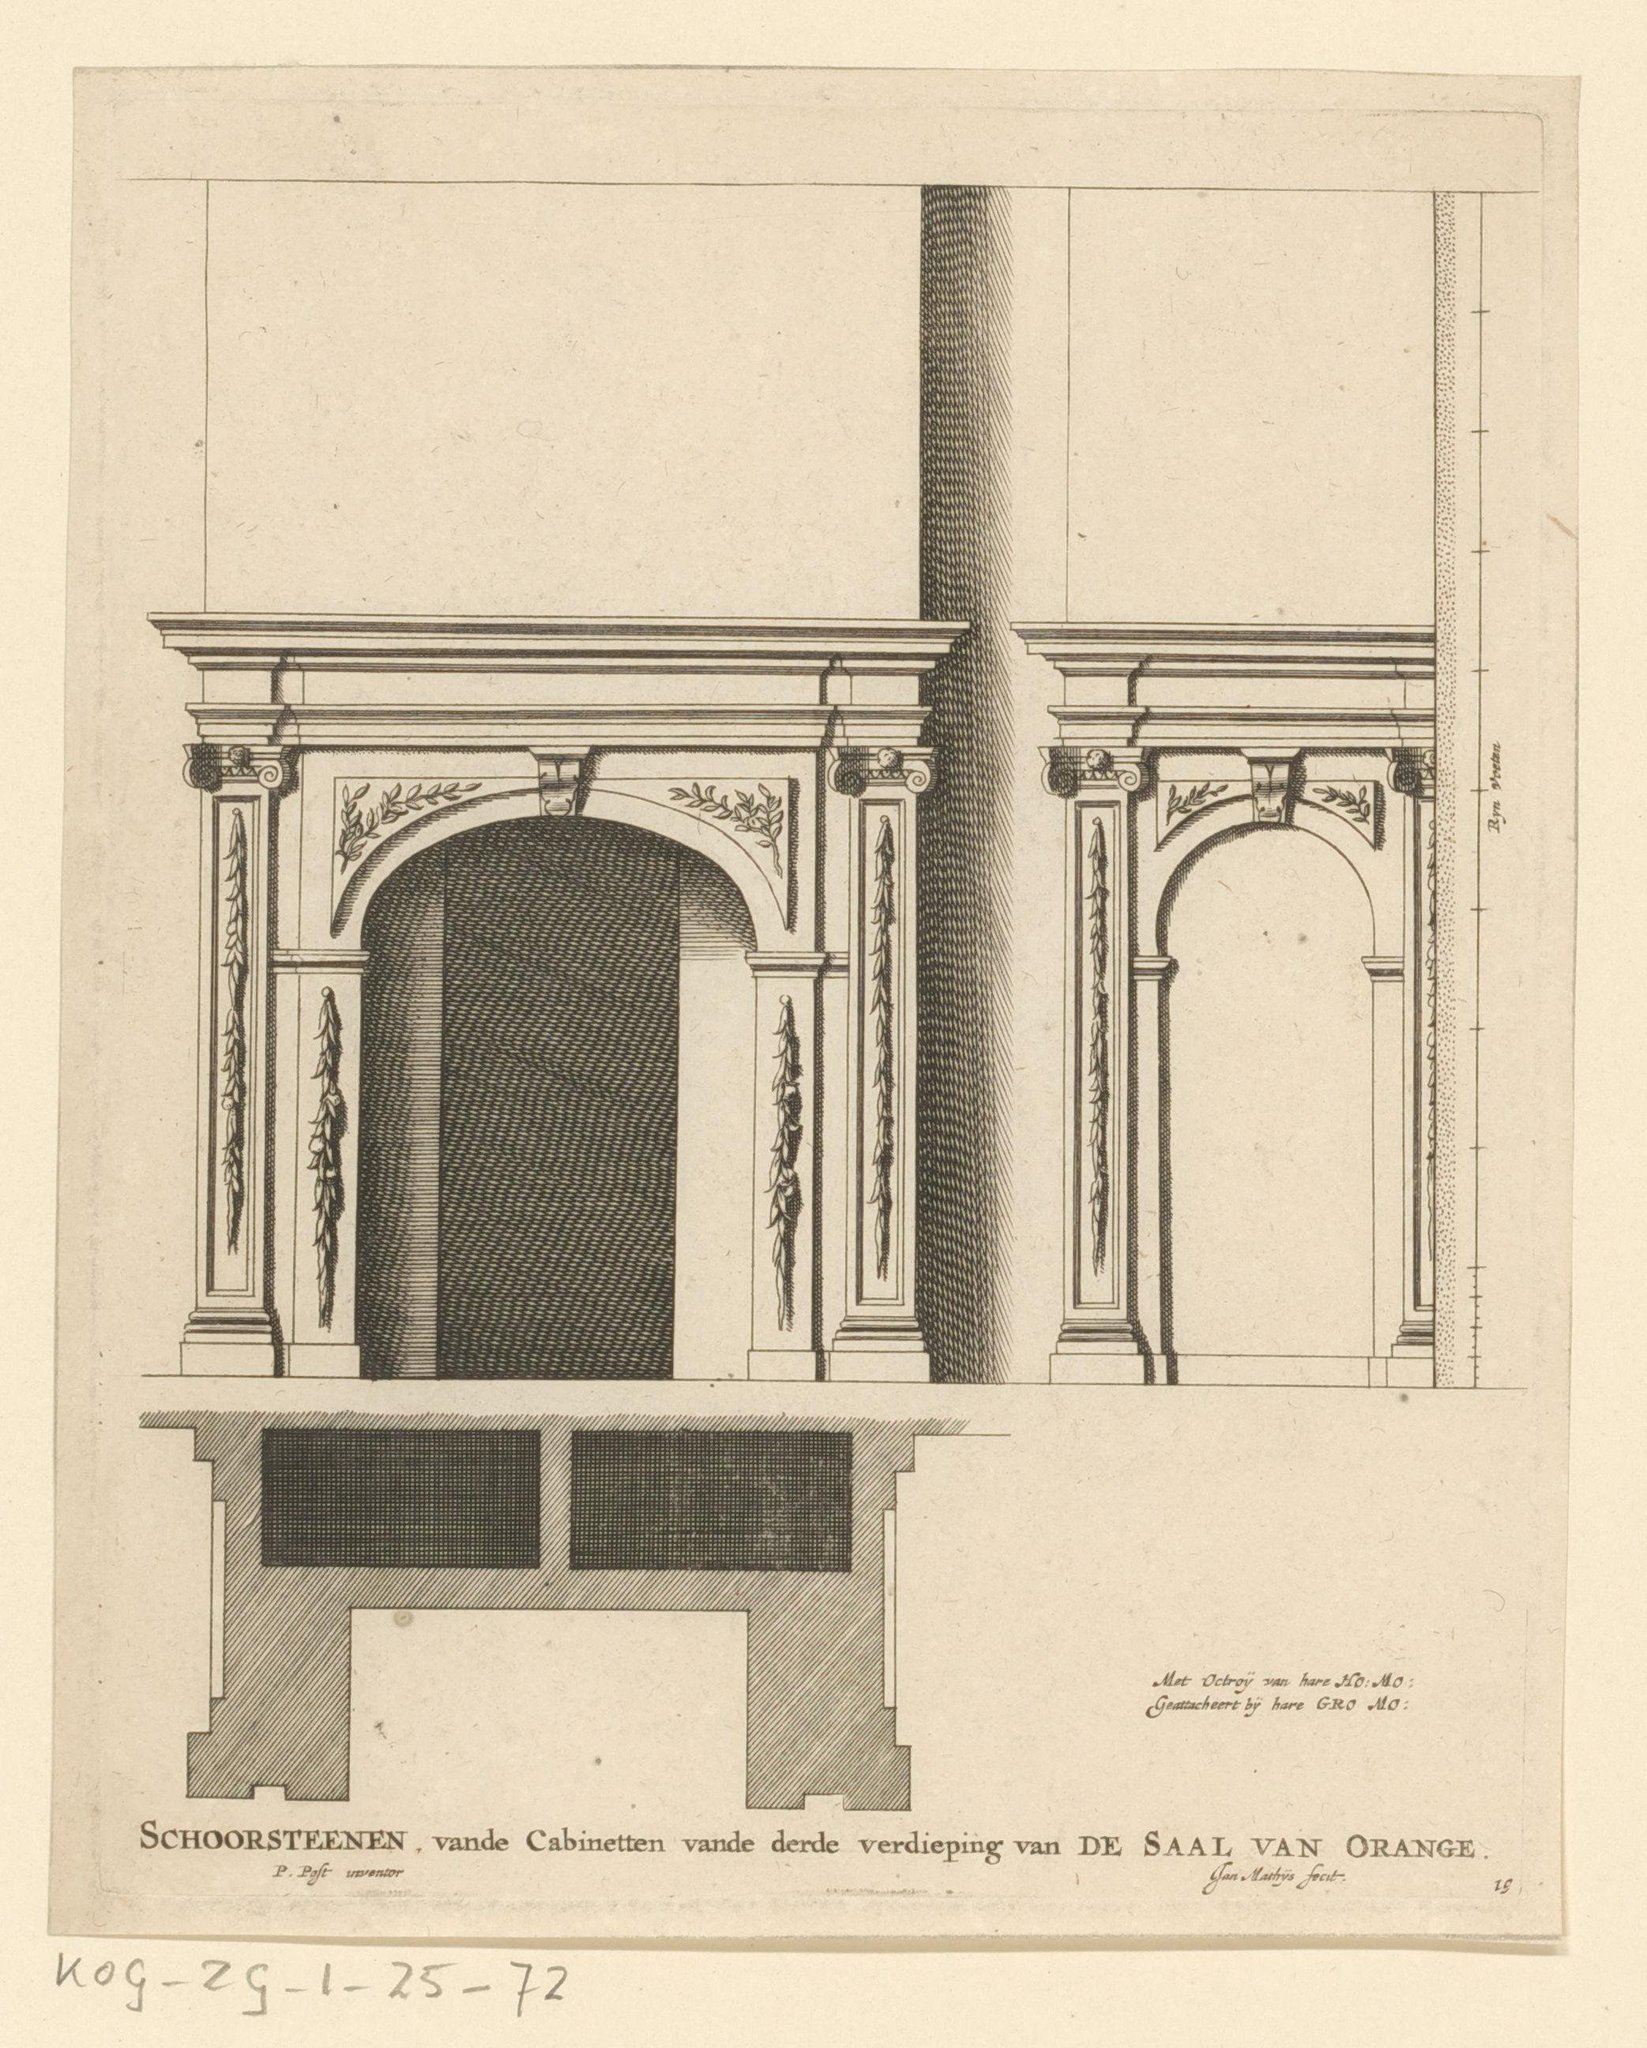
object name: ornament print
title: Schoorsteenen, vande Cabinetten vande derde verdieping van De Saal van Orange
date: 1669-1706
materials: paper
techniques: engraving, etching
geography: amsterdam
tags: chimney, chimney ornaments, chimney-piece, mantelpiece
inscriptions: : ‘Met Octrooy van hare HO: MO: Geattacheert bij hare GRO: MO:’, stamp:, stamp:, collector's mark: Lugt 1641a, collector's mark: Lugt 1641, stamp:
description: Titelprent is onderdeel van een serie bestaande uit een titelprent en 22 vervolg prenten. De serie is voor het eerst uitgegeven door Pieter Jansz. Post in Den Haag of Rotterdam. De huidige (tweede staat) is uitgegeven door Frederik de Wit tussen 1669 en 1706. De volgorde van de prenten is in deze serie veranderd. De prenten zijn een derde keer uitgegeven door Pieter van der Aa in 1715 te Leiden. Hier is de volgorde wederom aangepast.